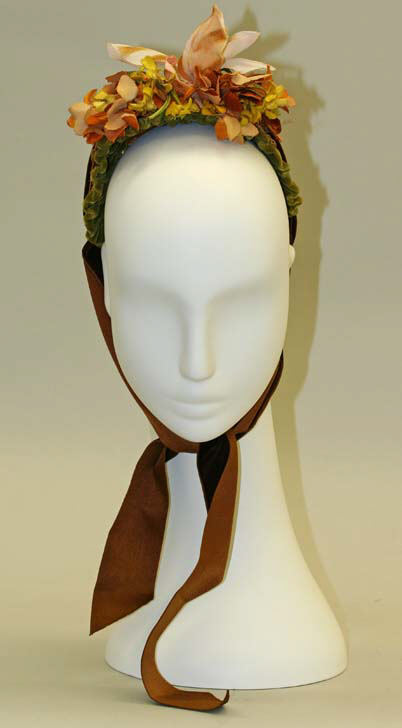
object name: bonnet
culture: american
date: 1881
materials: silk, fiber